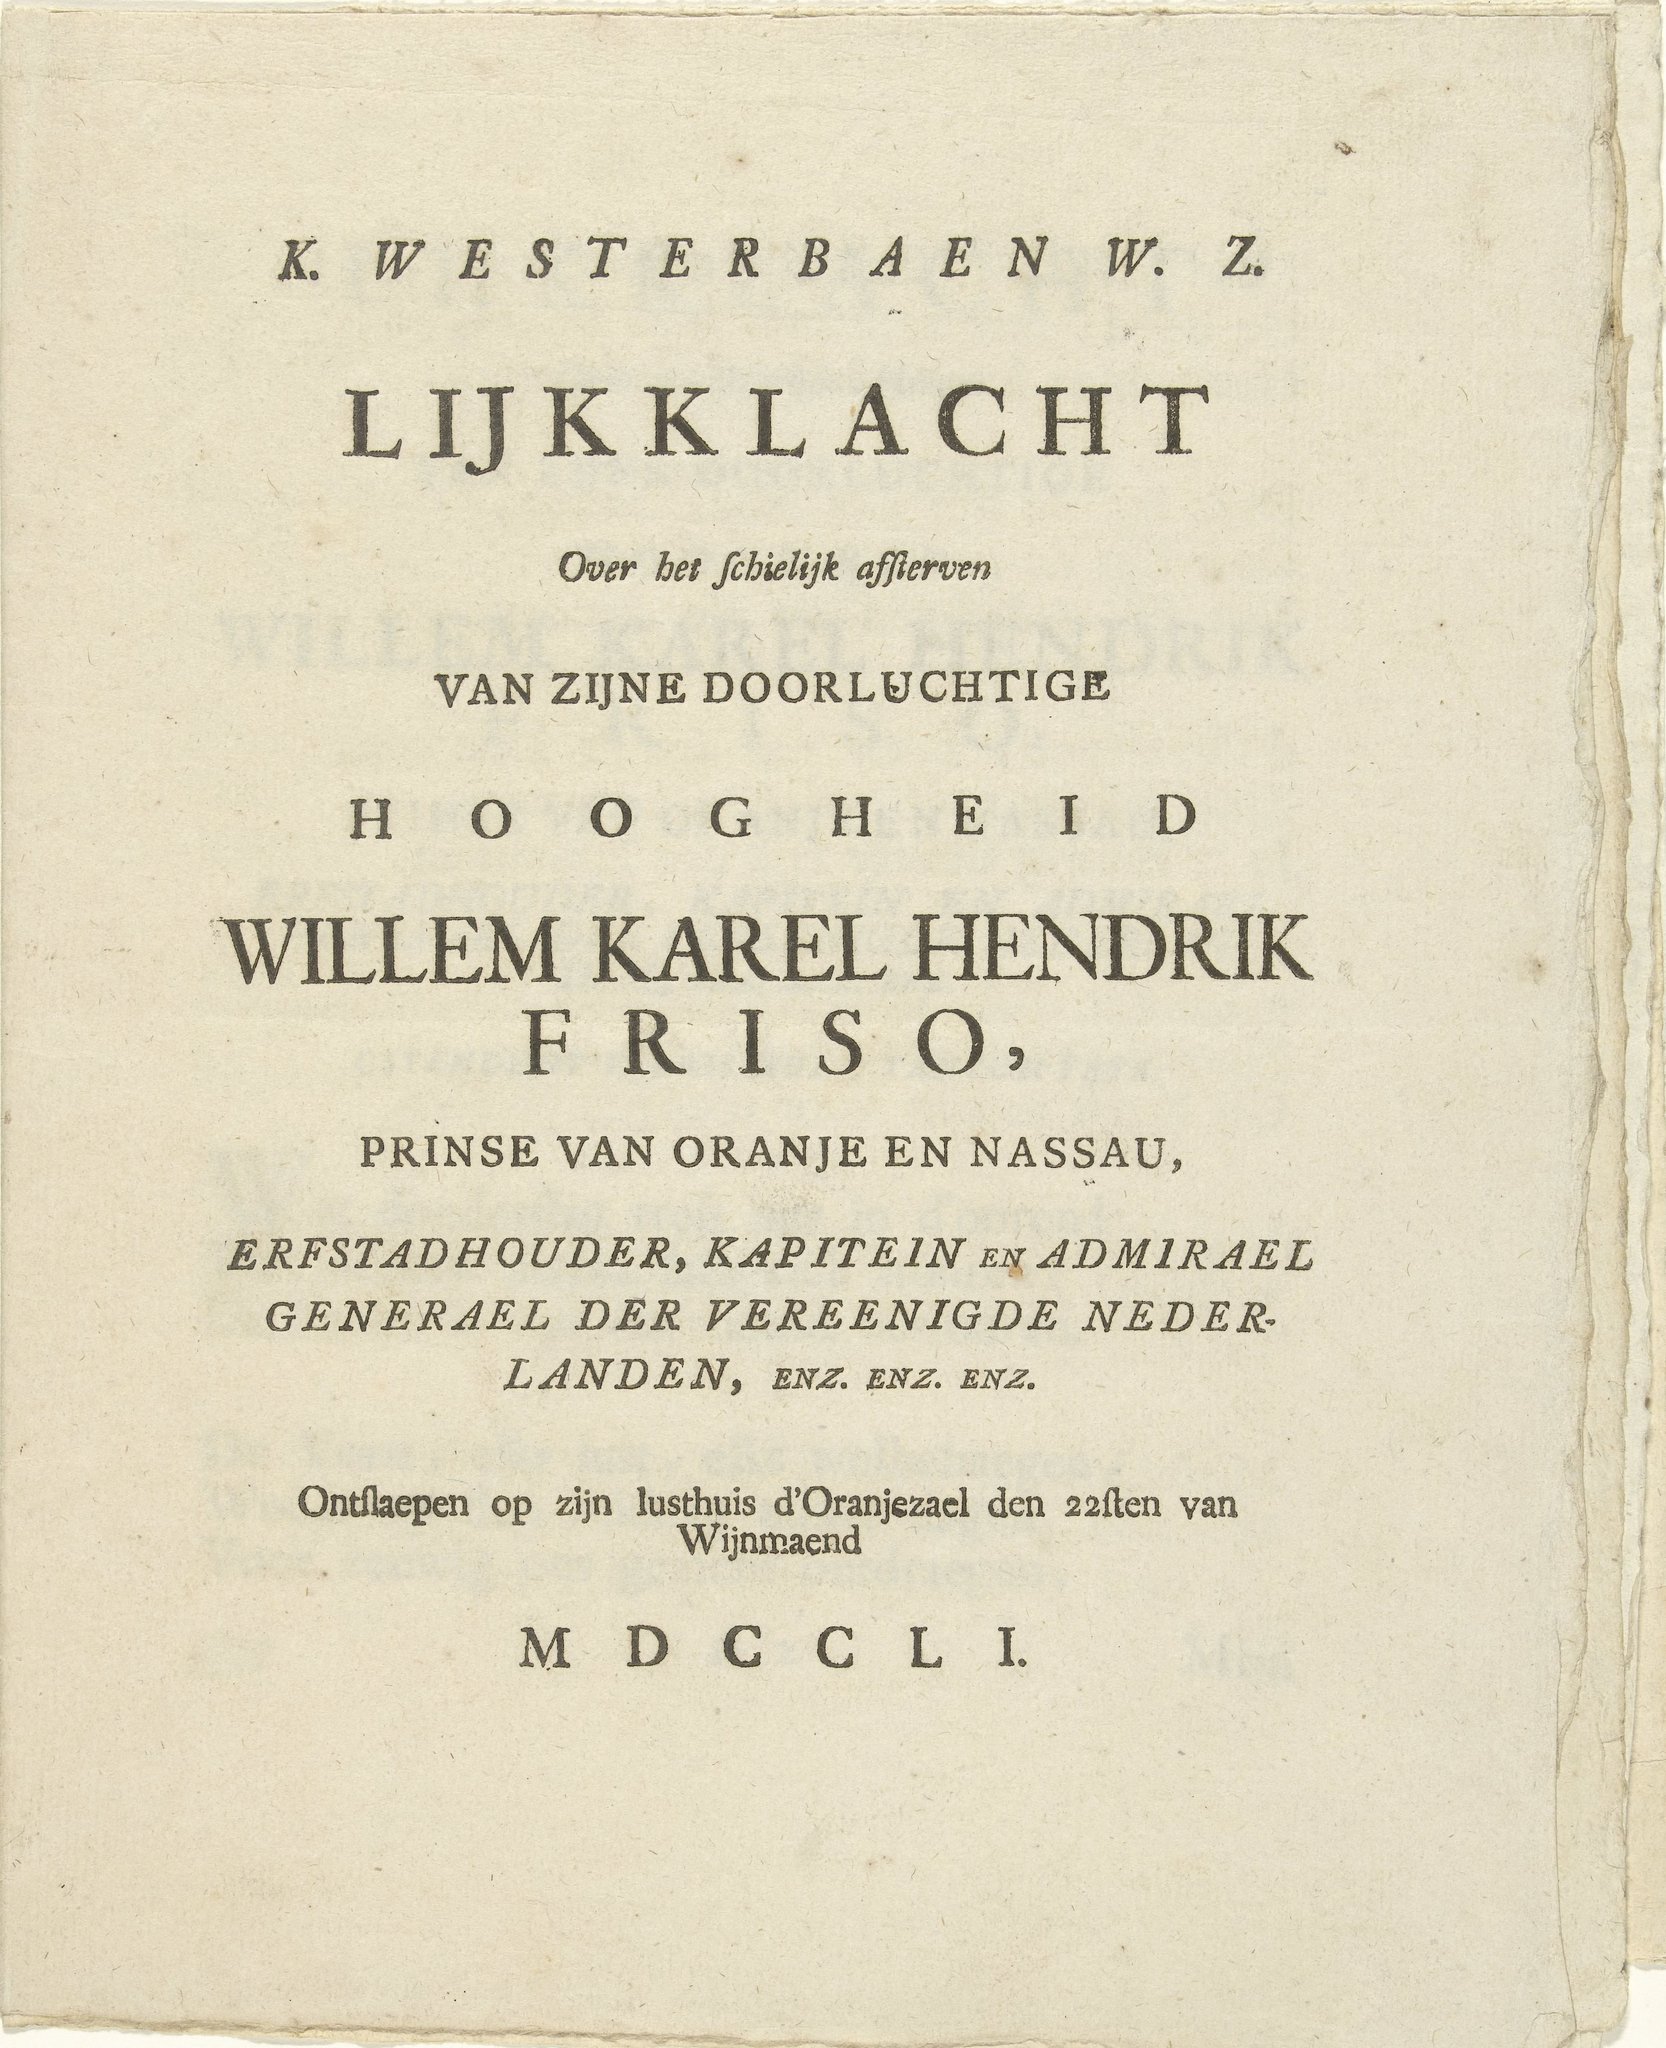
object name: text sheet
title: Lijkklacht over het schielijk afsterven van zijne doorluchtige hoogheid Willem Karel Hendrik Friso, Prinse van Oranje en Nassau (...)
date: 1751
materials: paper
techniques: letterpress printing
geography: rotterdam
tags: the hague, willem iv (prins van oranje-nassau)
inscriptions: collector's mark: Lugt 2228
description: Pamflet van twee dubbelgevouwen bladen met op zes bladzijden een lijkklacht op het overlijden van prins Willem IV op 22 oktober 1751.